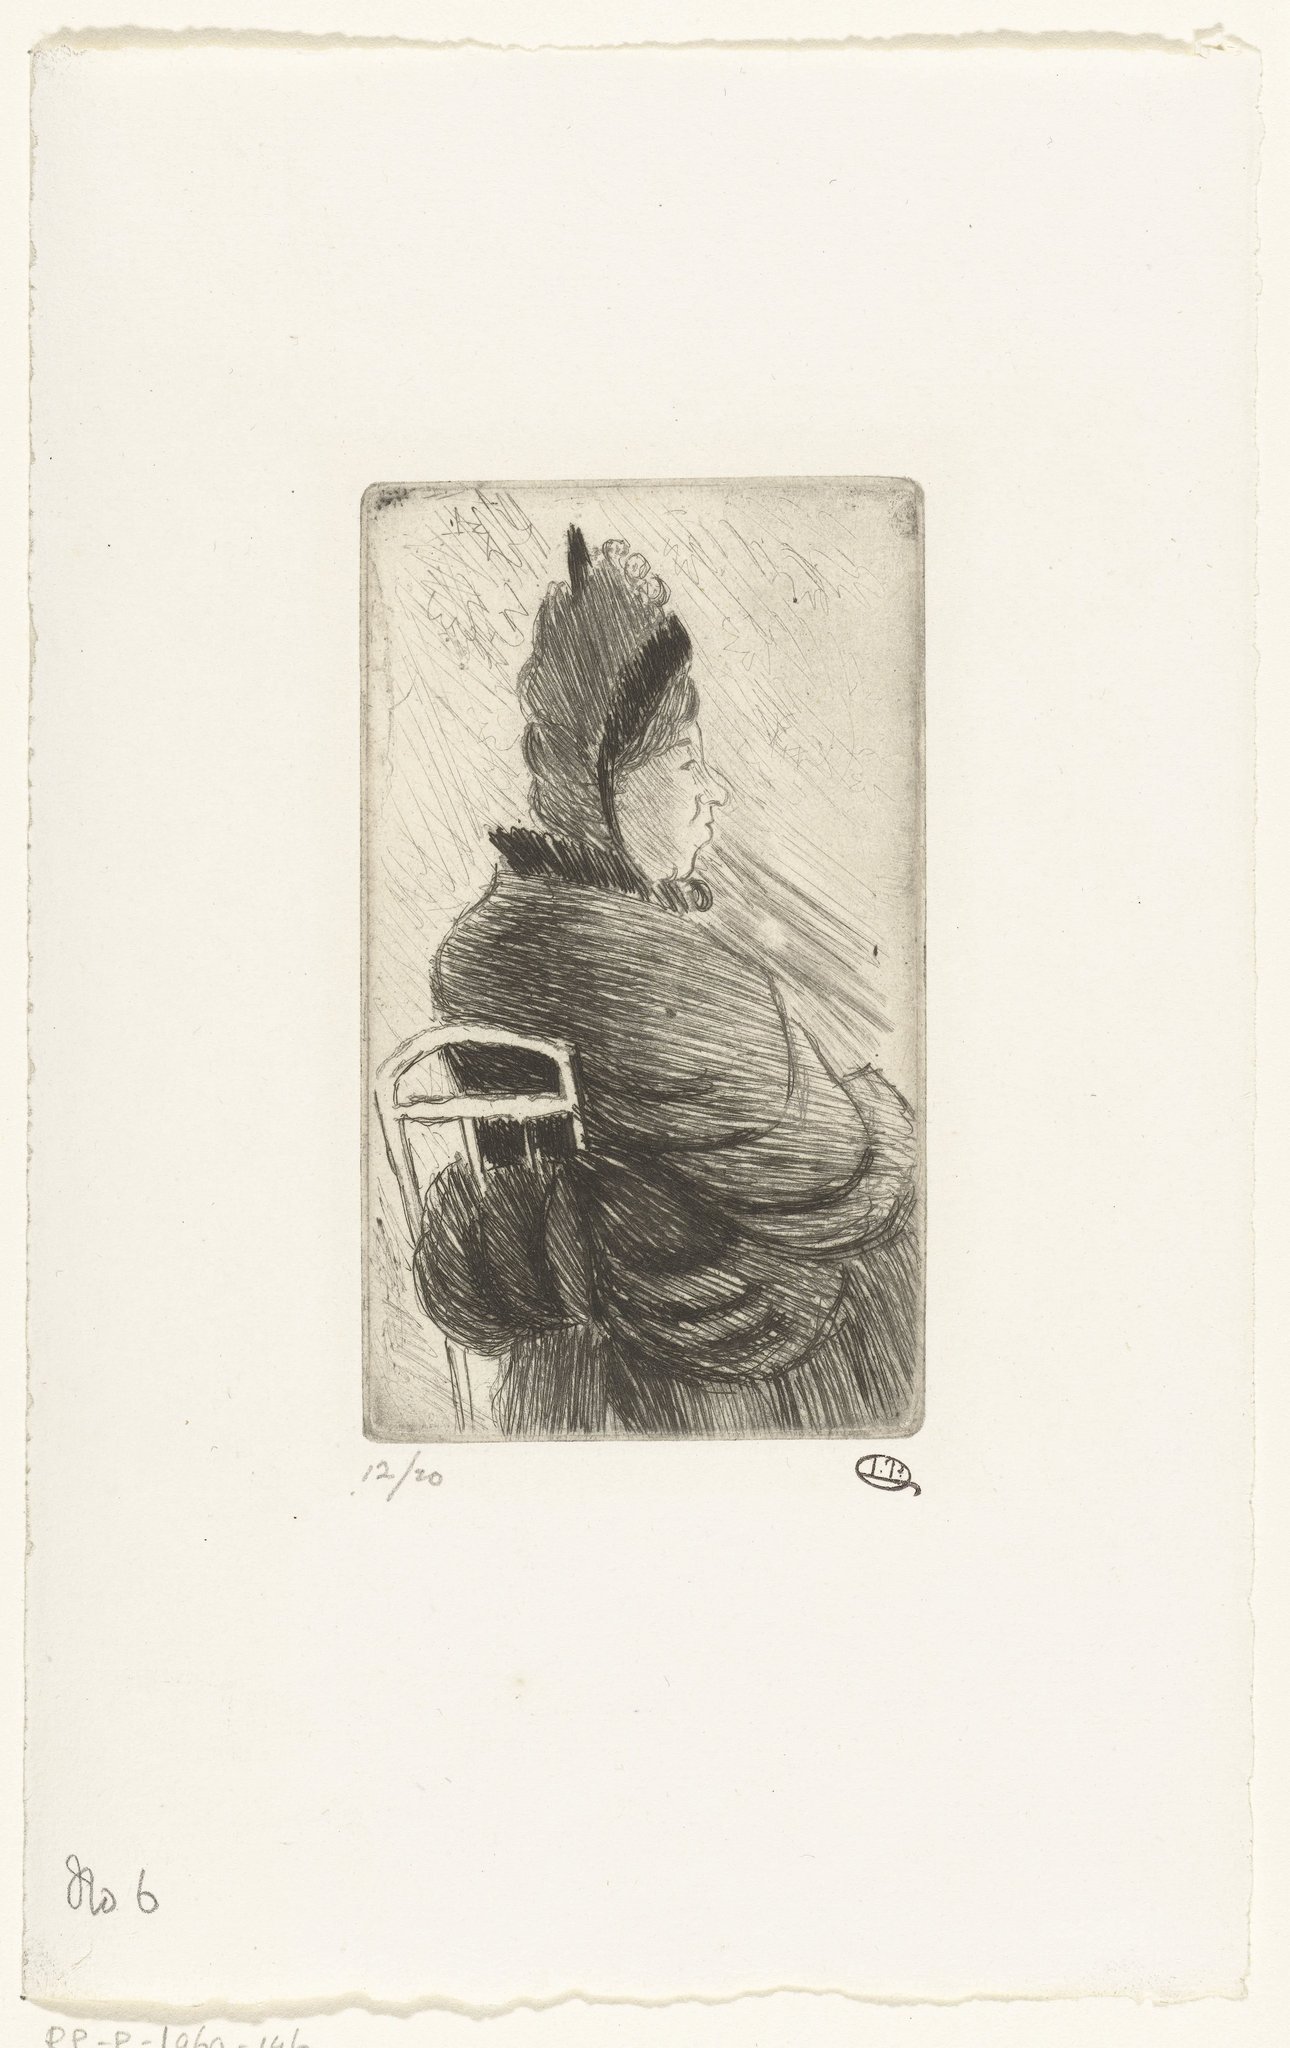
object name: print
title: Zittende vrouw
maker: lucien pissarro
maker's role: painter, print maker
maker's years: 1863-1944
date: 1873-1944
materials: paper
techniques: etching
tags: adult woman (+ sitting)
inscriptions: collector's mark: Lugt 2228, stamp: Lugt 1756b